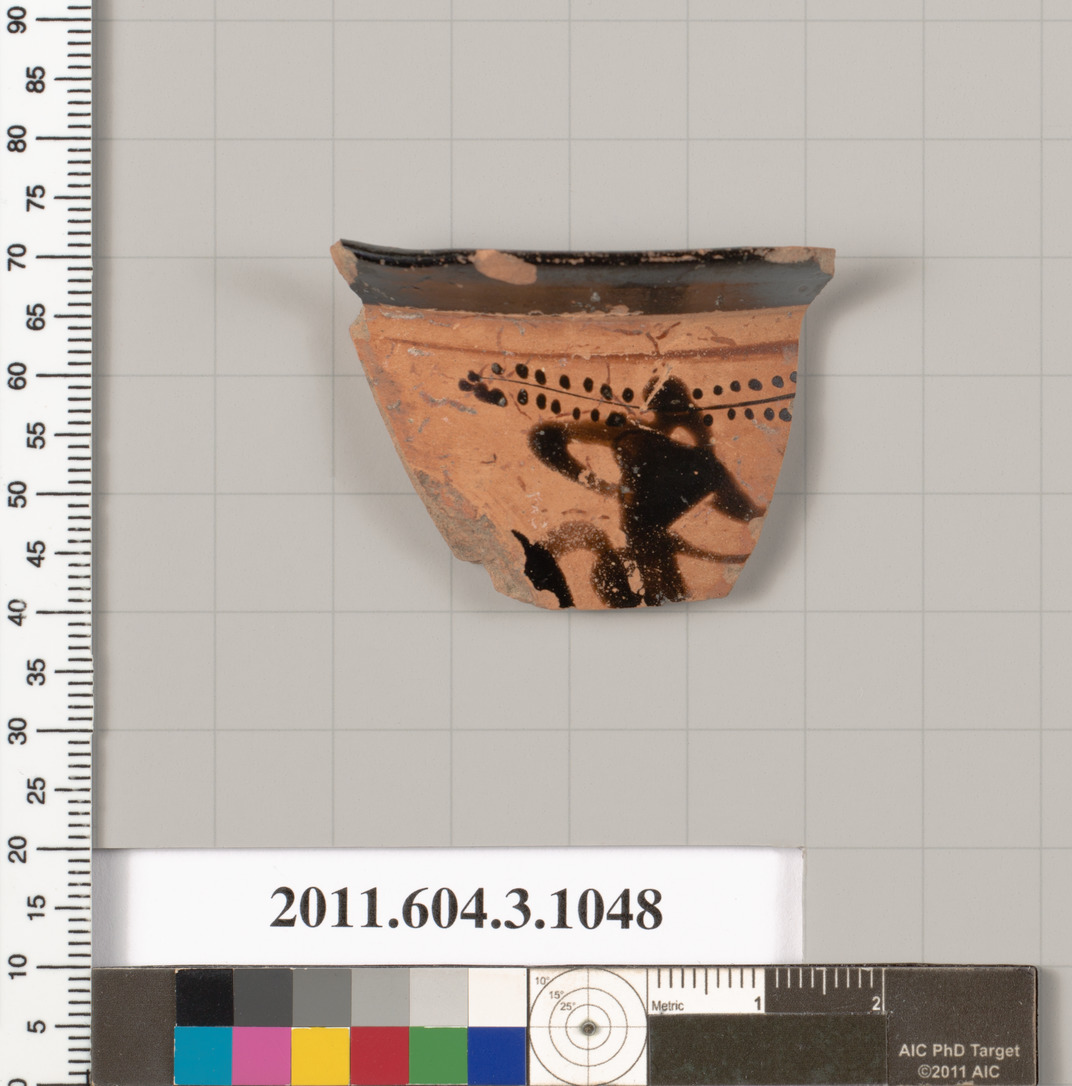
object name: mastoid fragment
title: Terracotta fragment of a mastoid (drinking cup with narrow base)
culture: greek, attic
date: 534-468 BCE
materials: terracotta